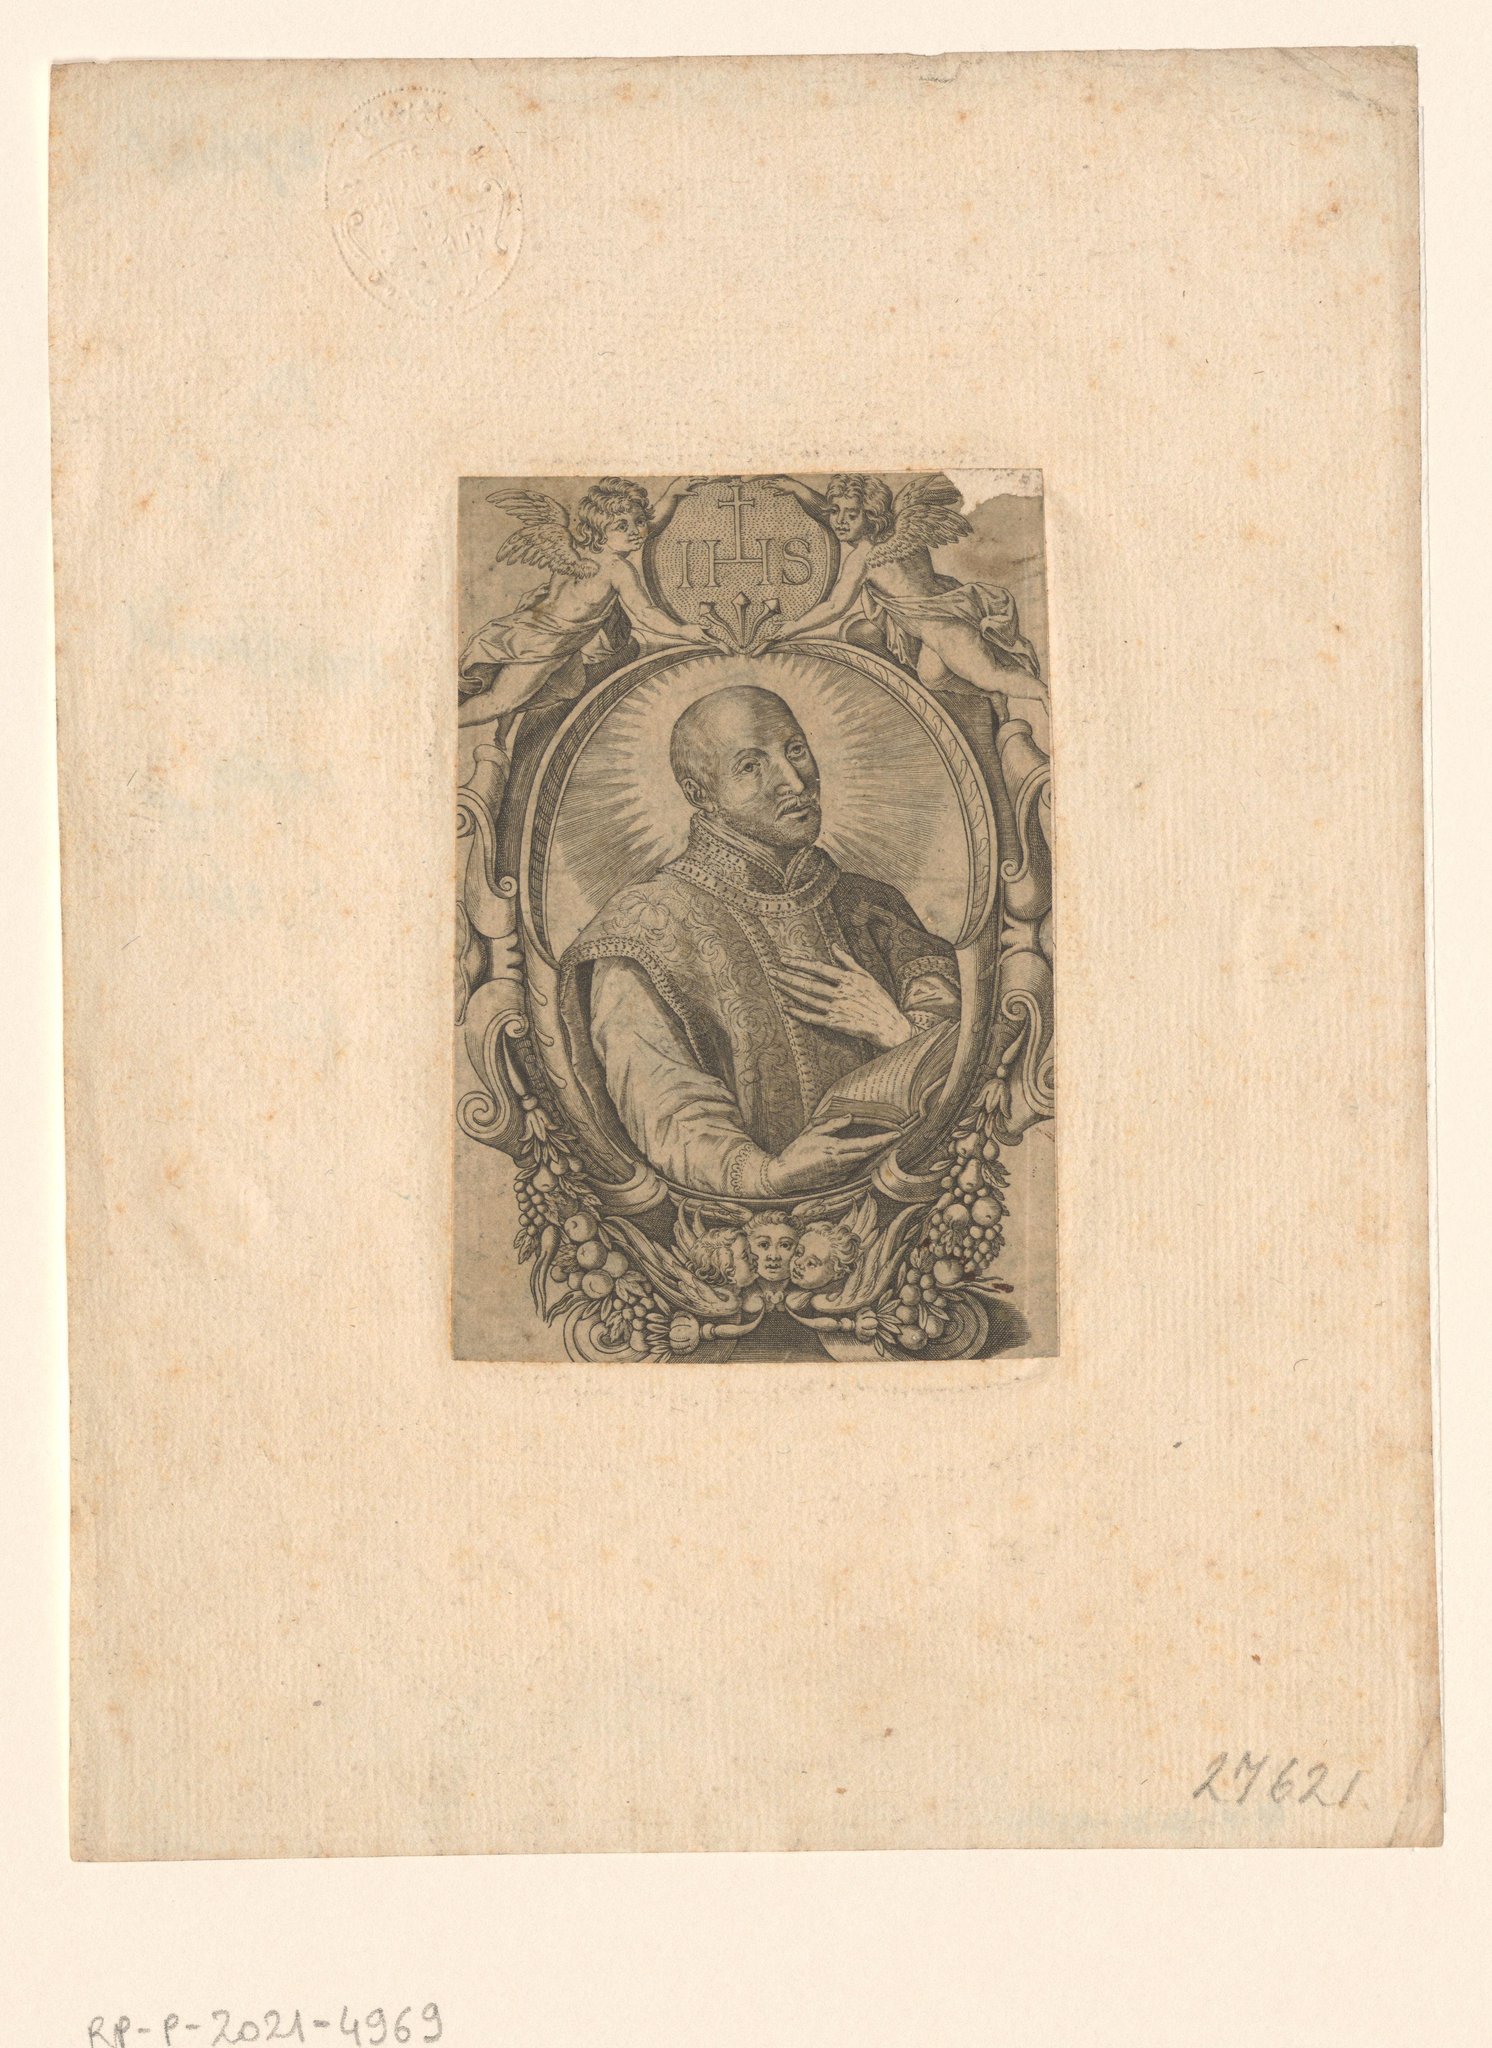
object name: print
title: H. Ignatius van Loyola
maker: Anonymous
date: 1600-1699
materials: paper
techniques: engraving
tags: rome, clergyman, cherubs, i.e. children's heads with wings, fruits and vegetables ~ ornament, historical persons, the founder of the jesuit order, ignatius of loyola; possible attributes: book (with 'ad majorem dei gloriam'), demon, dragon under feet, flames, flaming heart, globe, ihs monogram, skull (with crown), tears in eyes, torch, cupids: 'amores', 'amoretti', 'putti', the bible as a book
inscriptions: check stamp: Lugt 2690